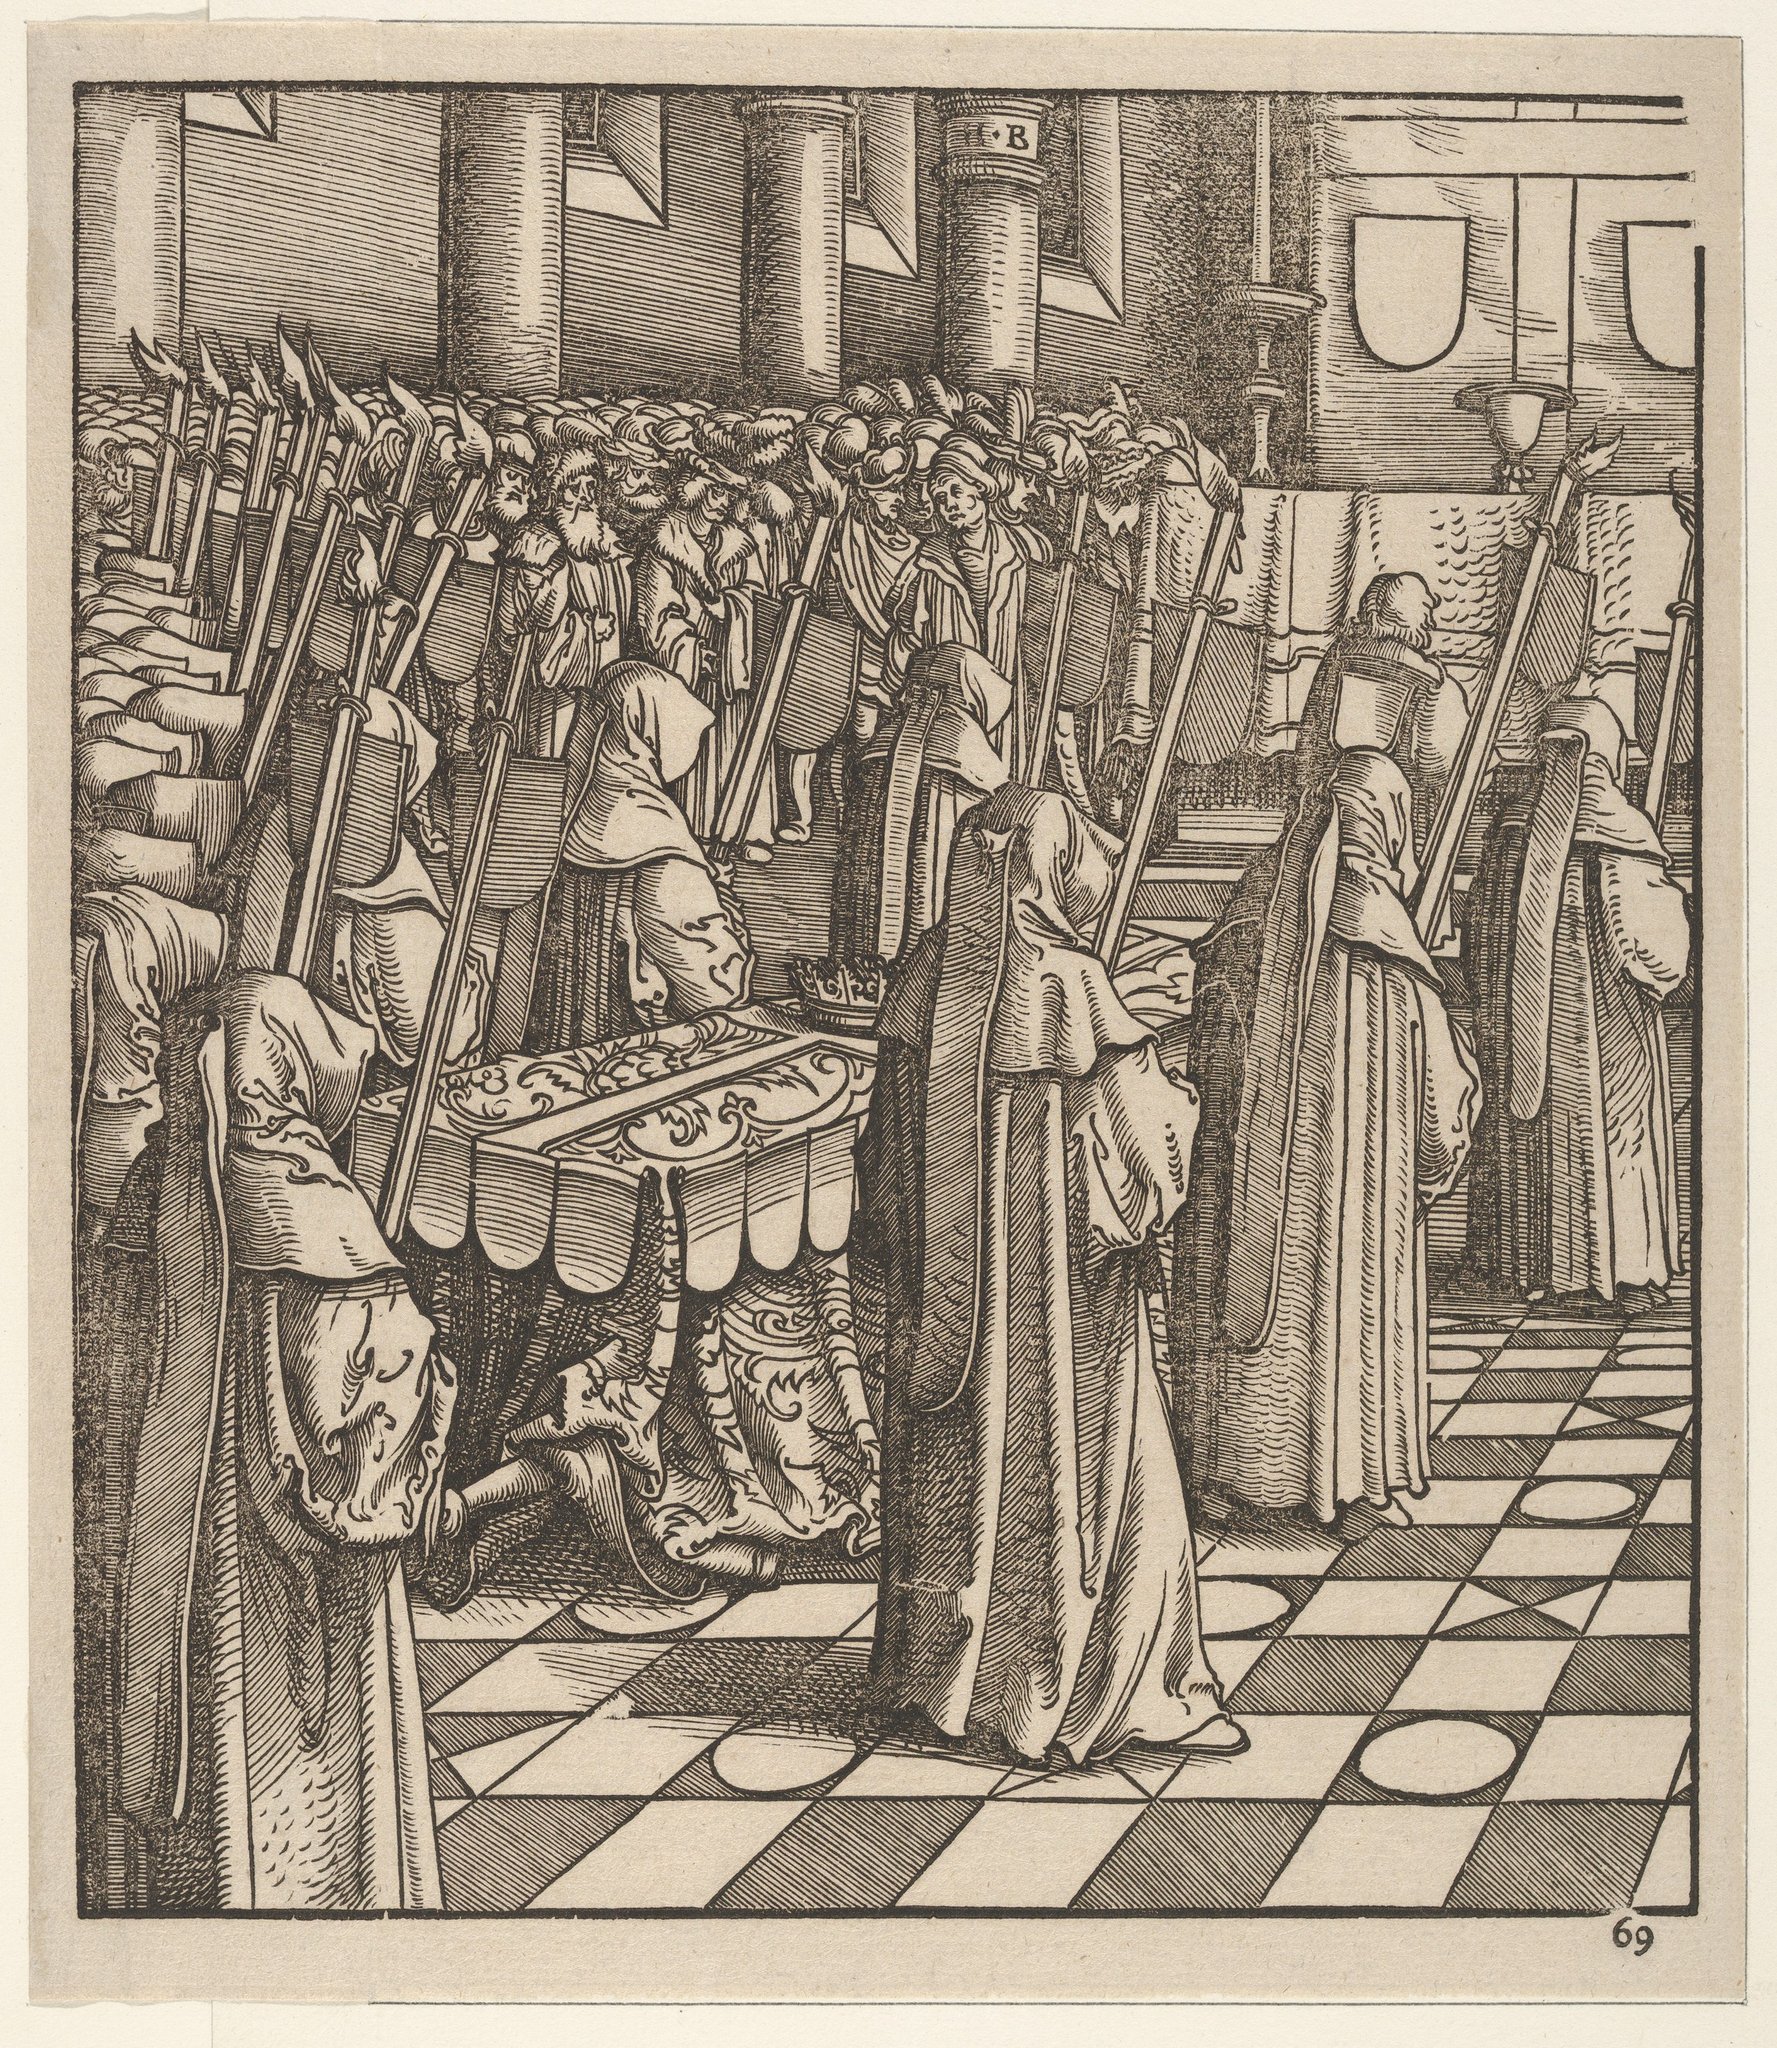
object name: print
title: The King of Feuereisen and His Only Daughter, from Der Weisskunig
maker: hans burgkmair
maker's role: artist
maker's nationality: german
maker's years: 1473-1531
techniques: woodcut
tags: kings,men,funerals